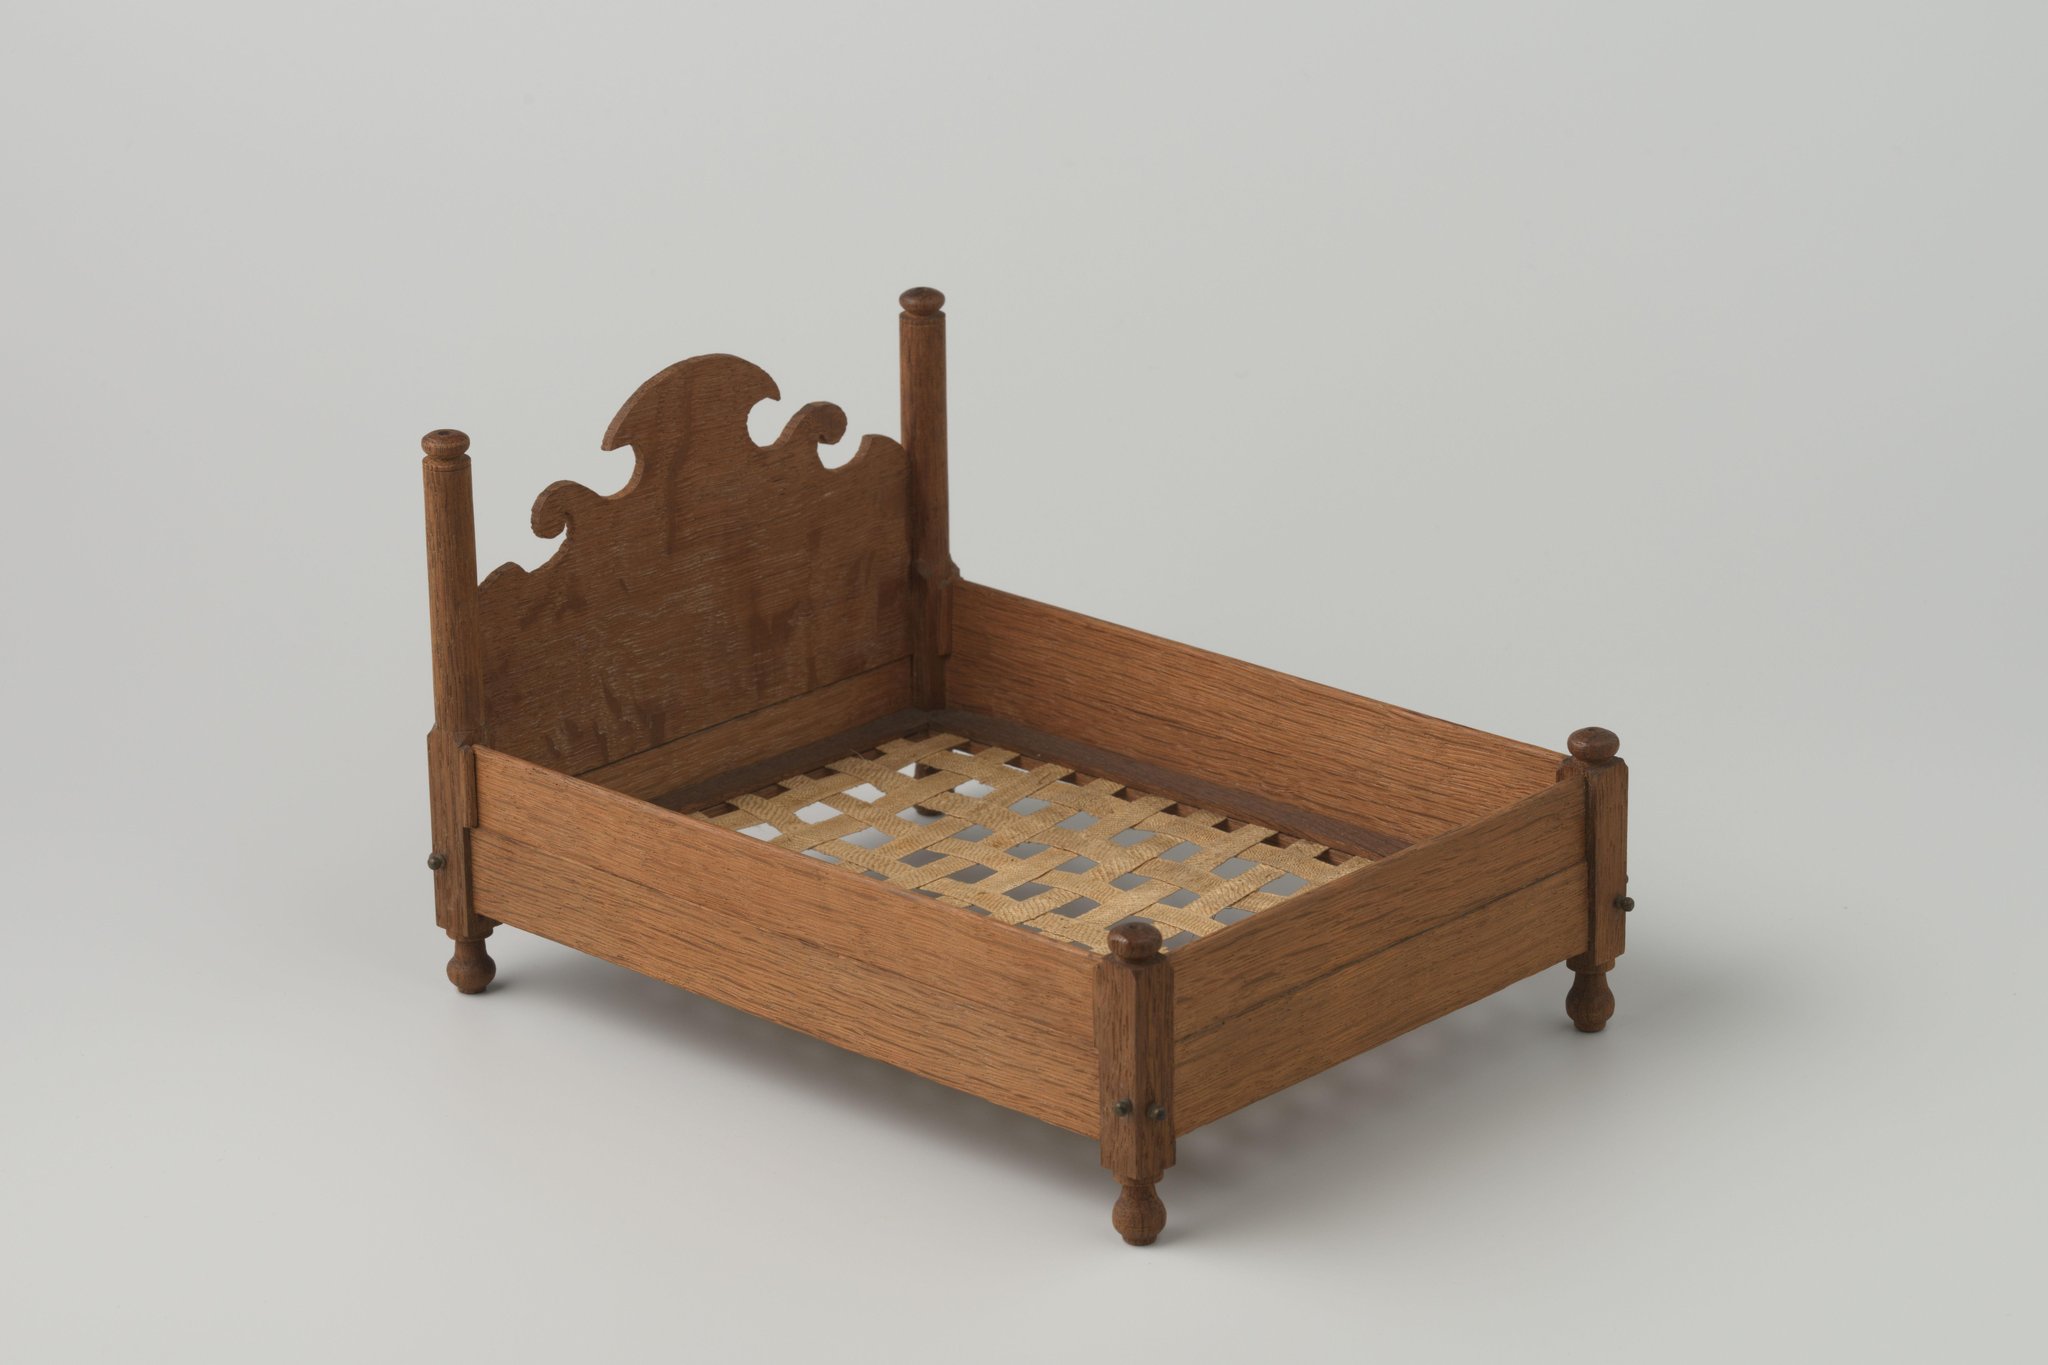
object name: miniature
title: Bed met verhoogd hoofdeinde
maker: Anonymous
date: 1690-1710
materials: brass, jute, linen, wood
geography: amsterdam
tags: bed